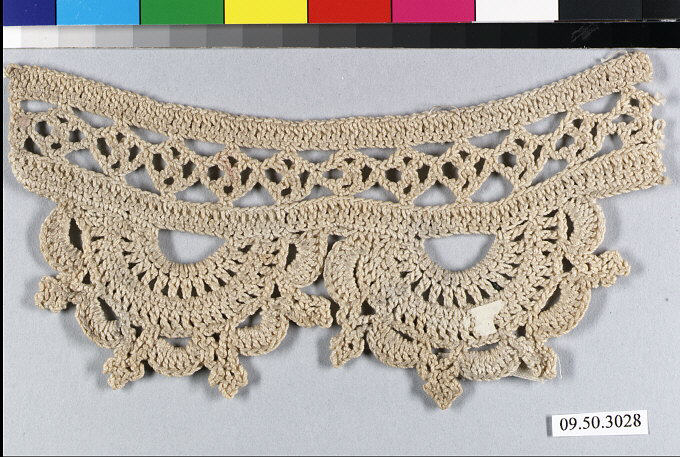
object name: sample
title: Crochet Work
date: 1801-1900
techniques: crochet